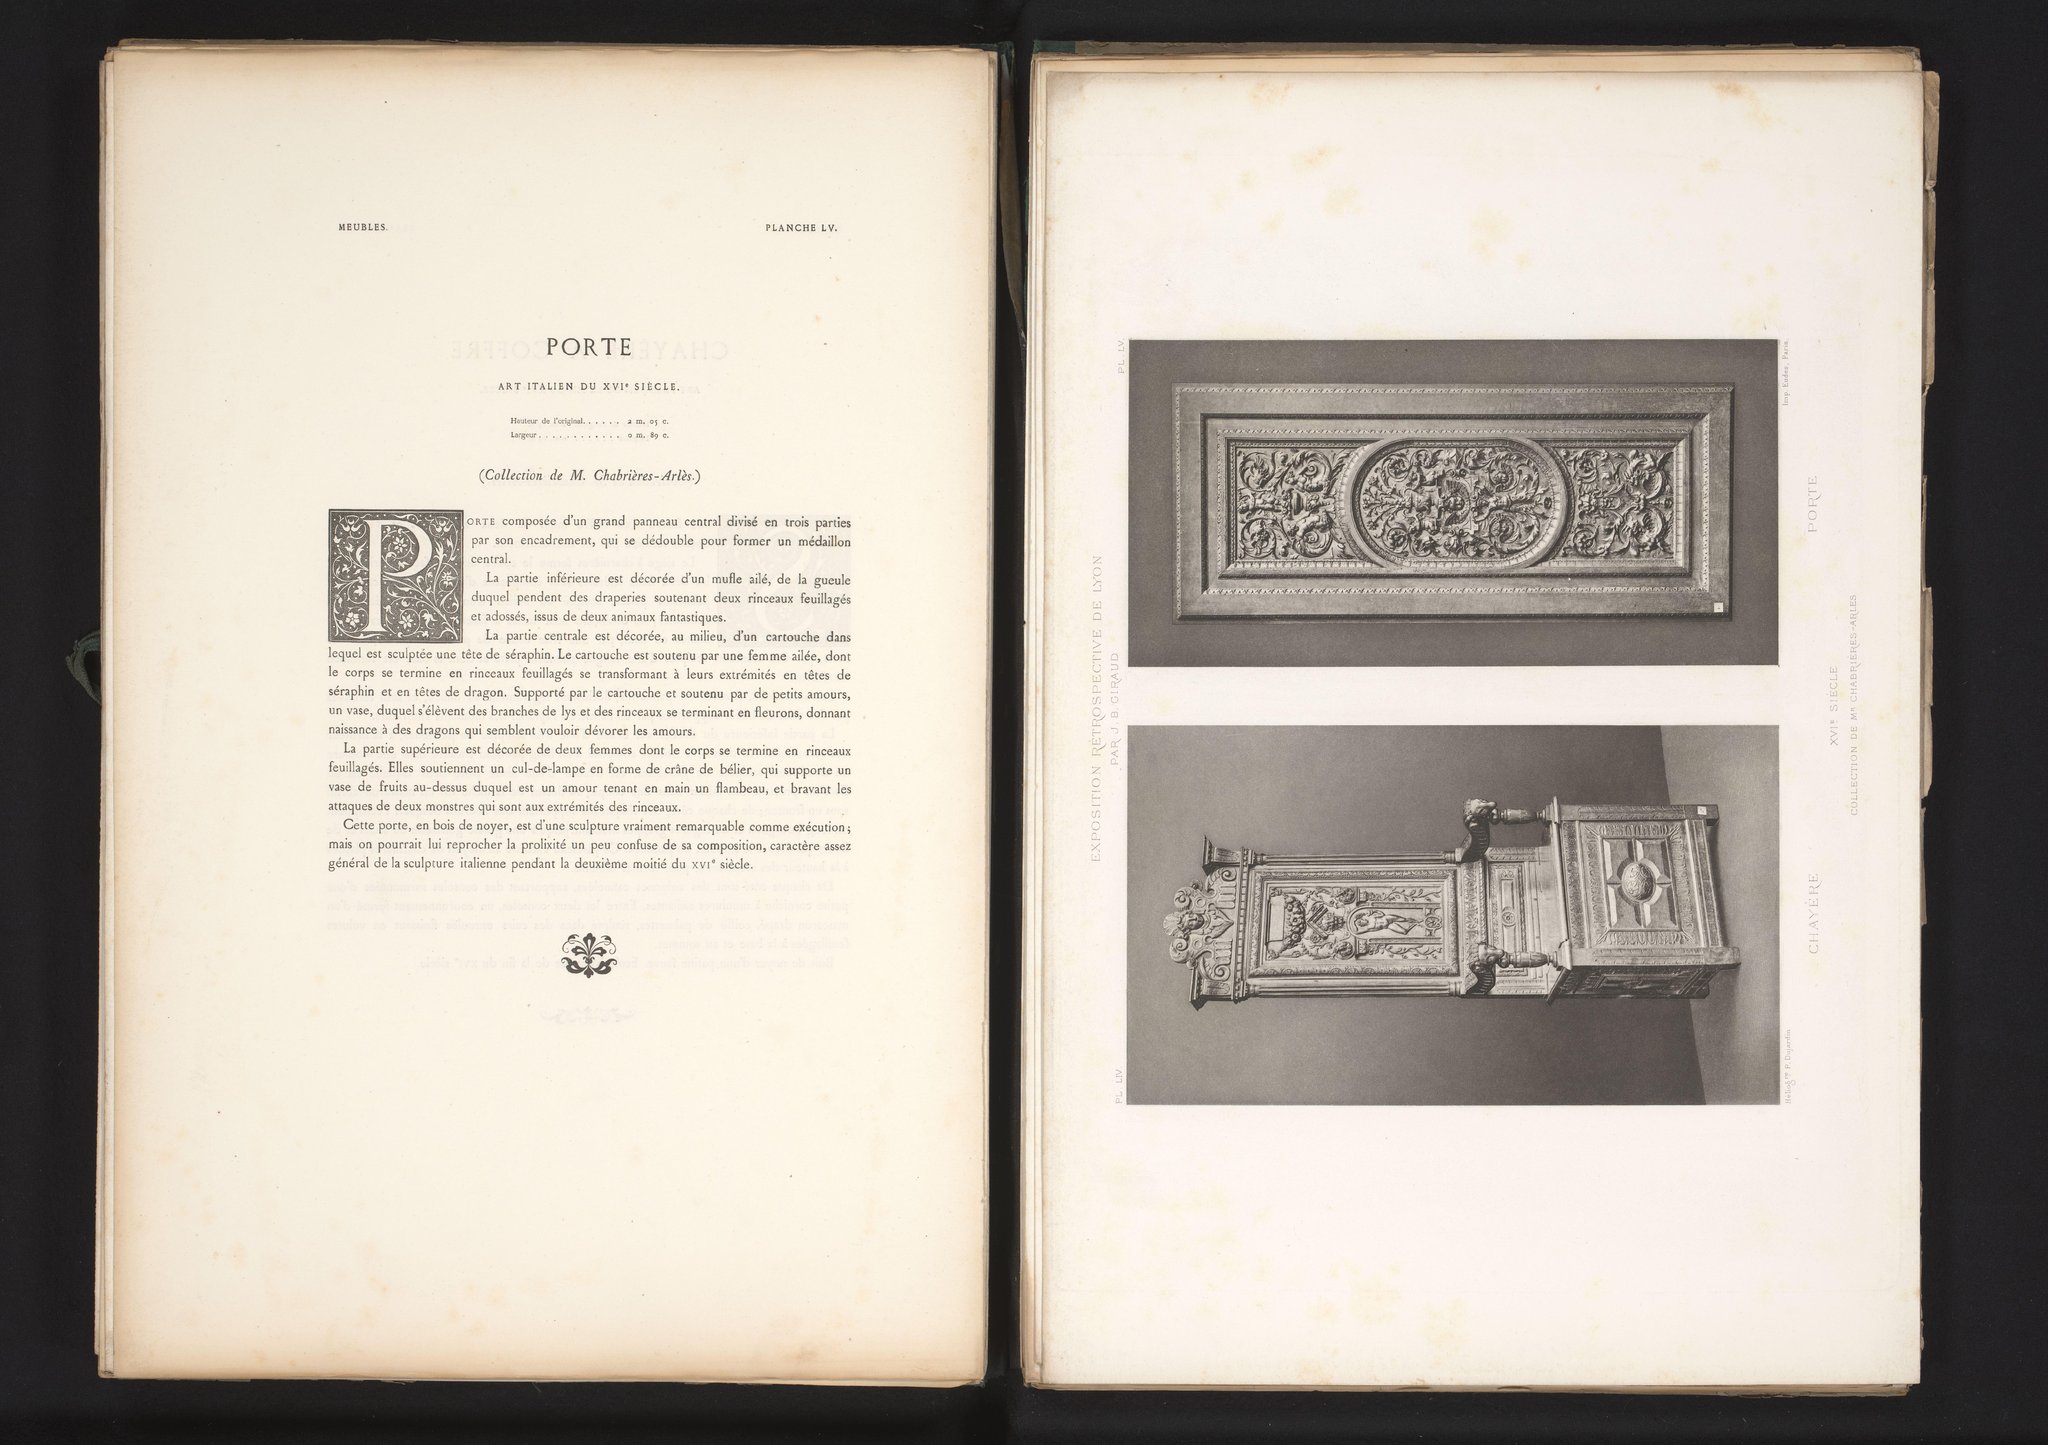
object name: photomechanical print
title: 16de-eeuwse zetel van hout en een 16de-eeuwse deur van hout, op de Exposition Rétrospective van 1877 in Lyon, Frankrijk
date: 1877-1878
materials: paper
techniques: photoaquatint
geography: paris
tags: chair (+ wood and other phytogenic material), door, lyon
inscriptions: inscription: ‘EXPOSITION RÉTROSPECTIVE DE LYON/ PAR J. B. GIRAUD.’, inscription: ‘CHAYÈRE/ PORTE/ XVIe SIÈCLE/ COLLECTION DE Mr CHABRIÈRES-ARLES.’, number: ‘PL. LIV.’, number: ‘PL. LV.’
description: Deze prenten maken deel uit van een omslag met 79 prenten op 54 bladen en 65 tekstbladen.